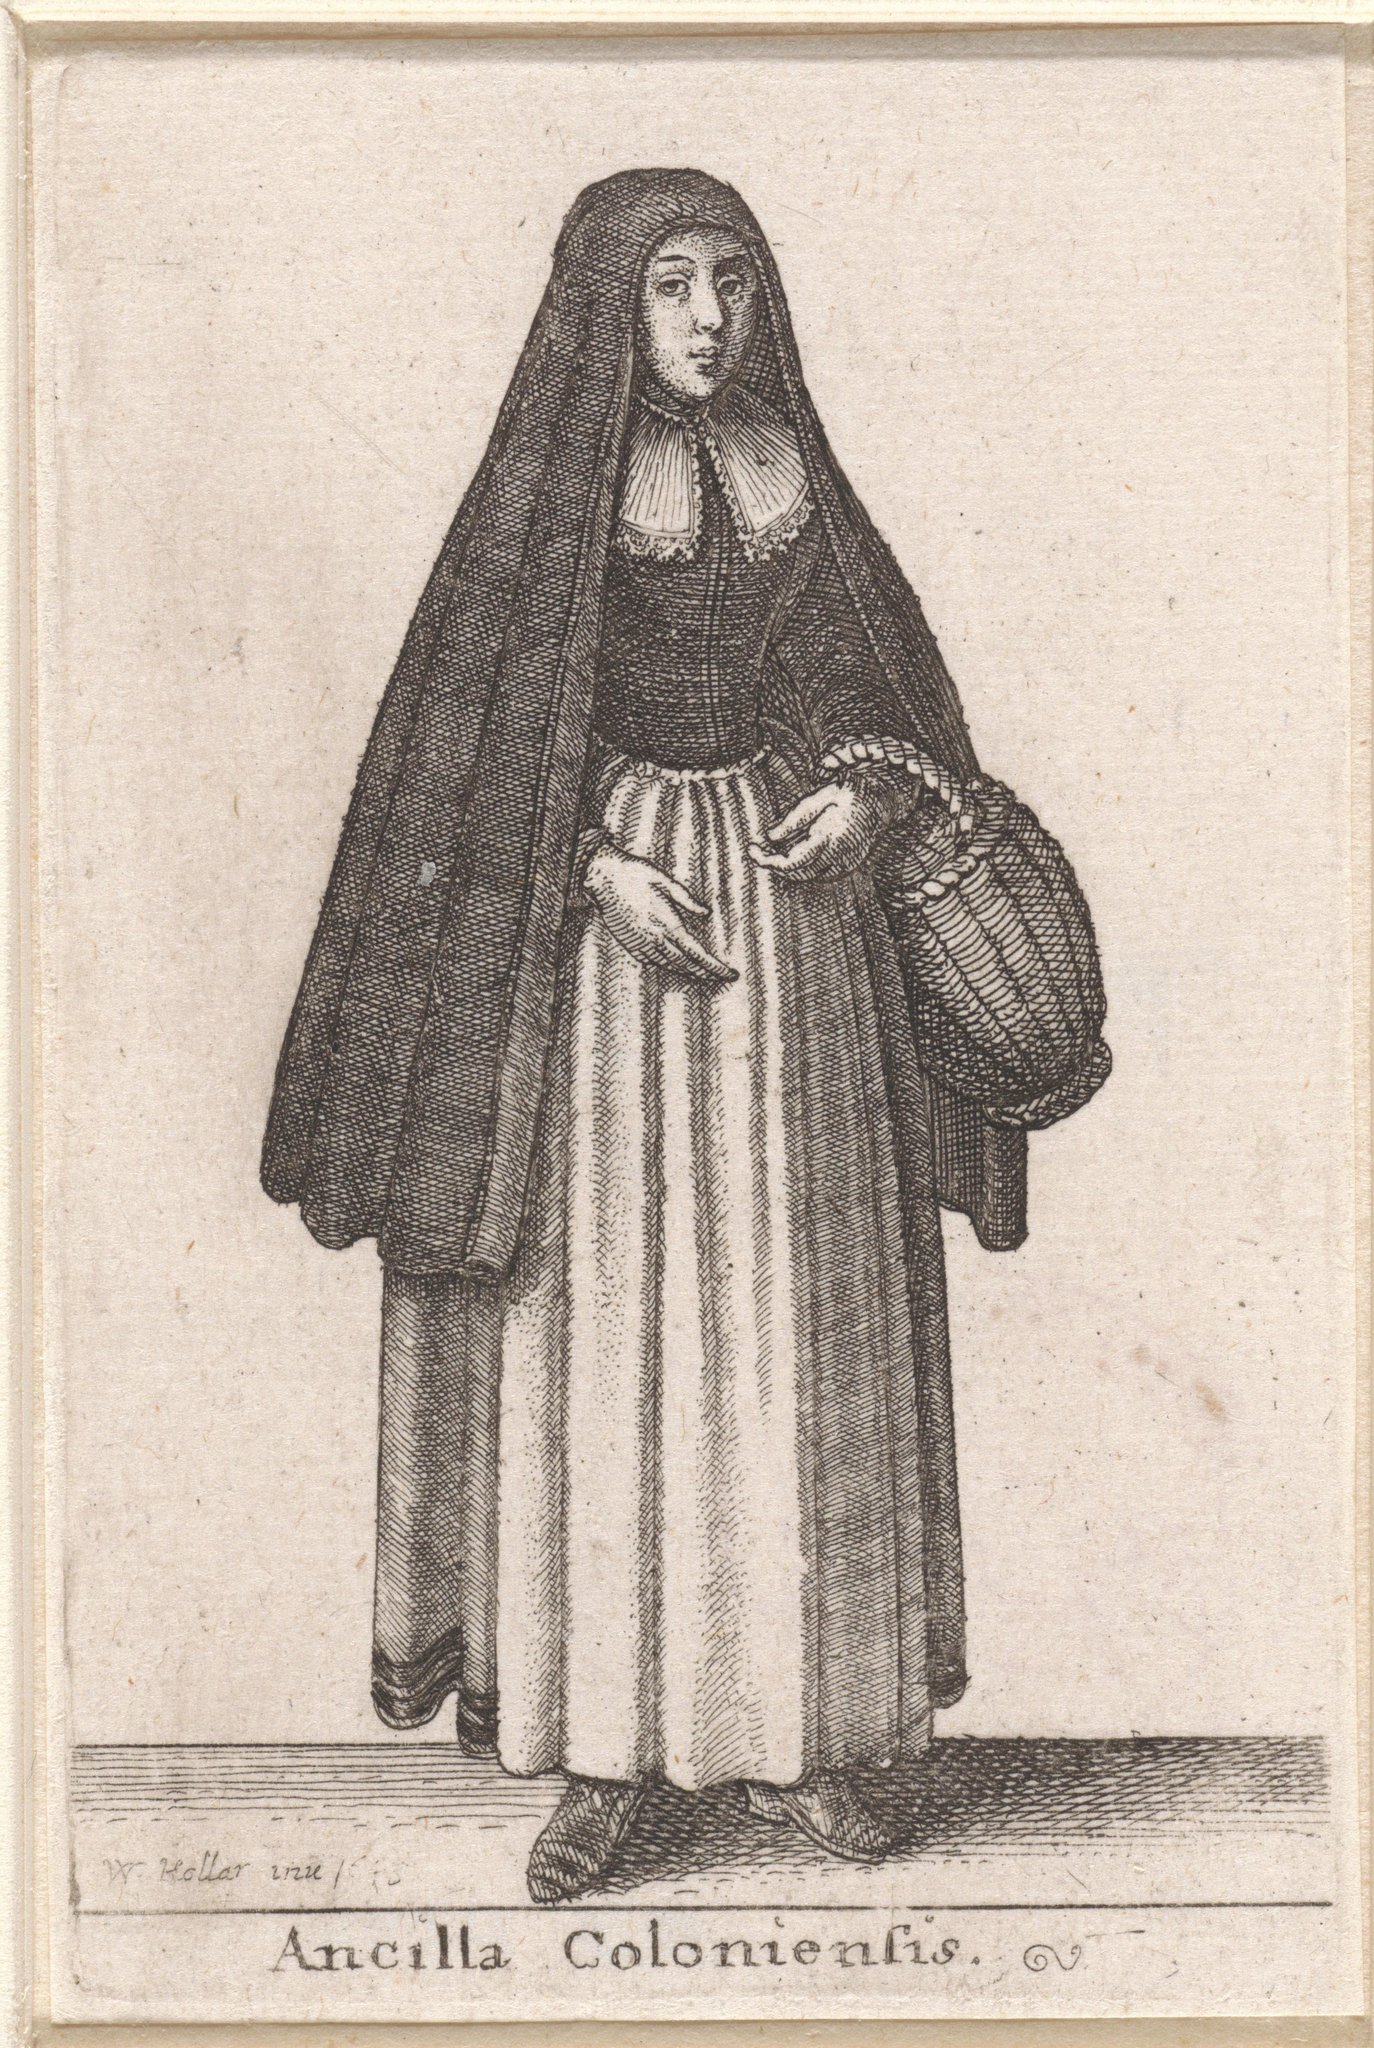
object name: costume print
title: Ancilla Coloniensis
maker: wenceslaus hollar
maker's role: draughtsman, print maker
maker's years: 1607-1677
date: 1643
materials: paper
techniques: etching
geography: london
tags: europeans: germans (+ women), cape (+ women's clothes), neck-gear: collar (+ women's clothes), clothes, costume (+ women's clothes), carrying something in basket, bag, rucksack, etc., skirt (+ women's clothes), apron (+ women's clothes), cologne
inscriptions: collector's mark: Lugt 240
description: Een dienstmeid uit Keulen, met een heuplange wijde cape, die rond het voorhoofd aansluit. Gerimpelde platte kraag afgezet met kanten strook. Nauwsluitend lijf met bragoenen en strakke mouwen op enkellange gerimpelde rok van lichte kleur versierd met twee horizontale banden boven de zoom. Gerimpeld wit schort. Open schoenen met blokhak. Diepe mand aan de linkerarm.